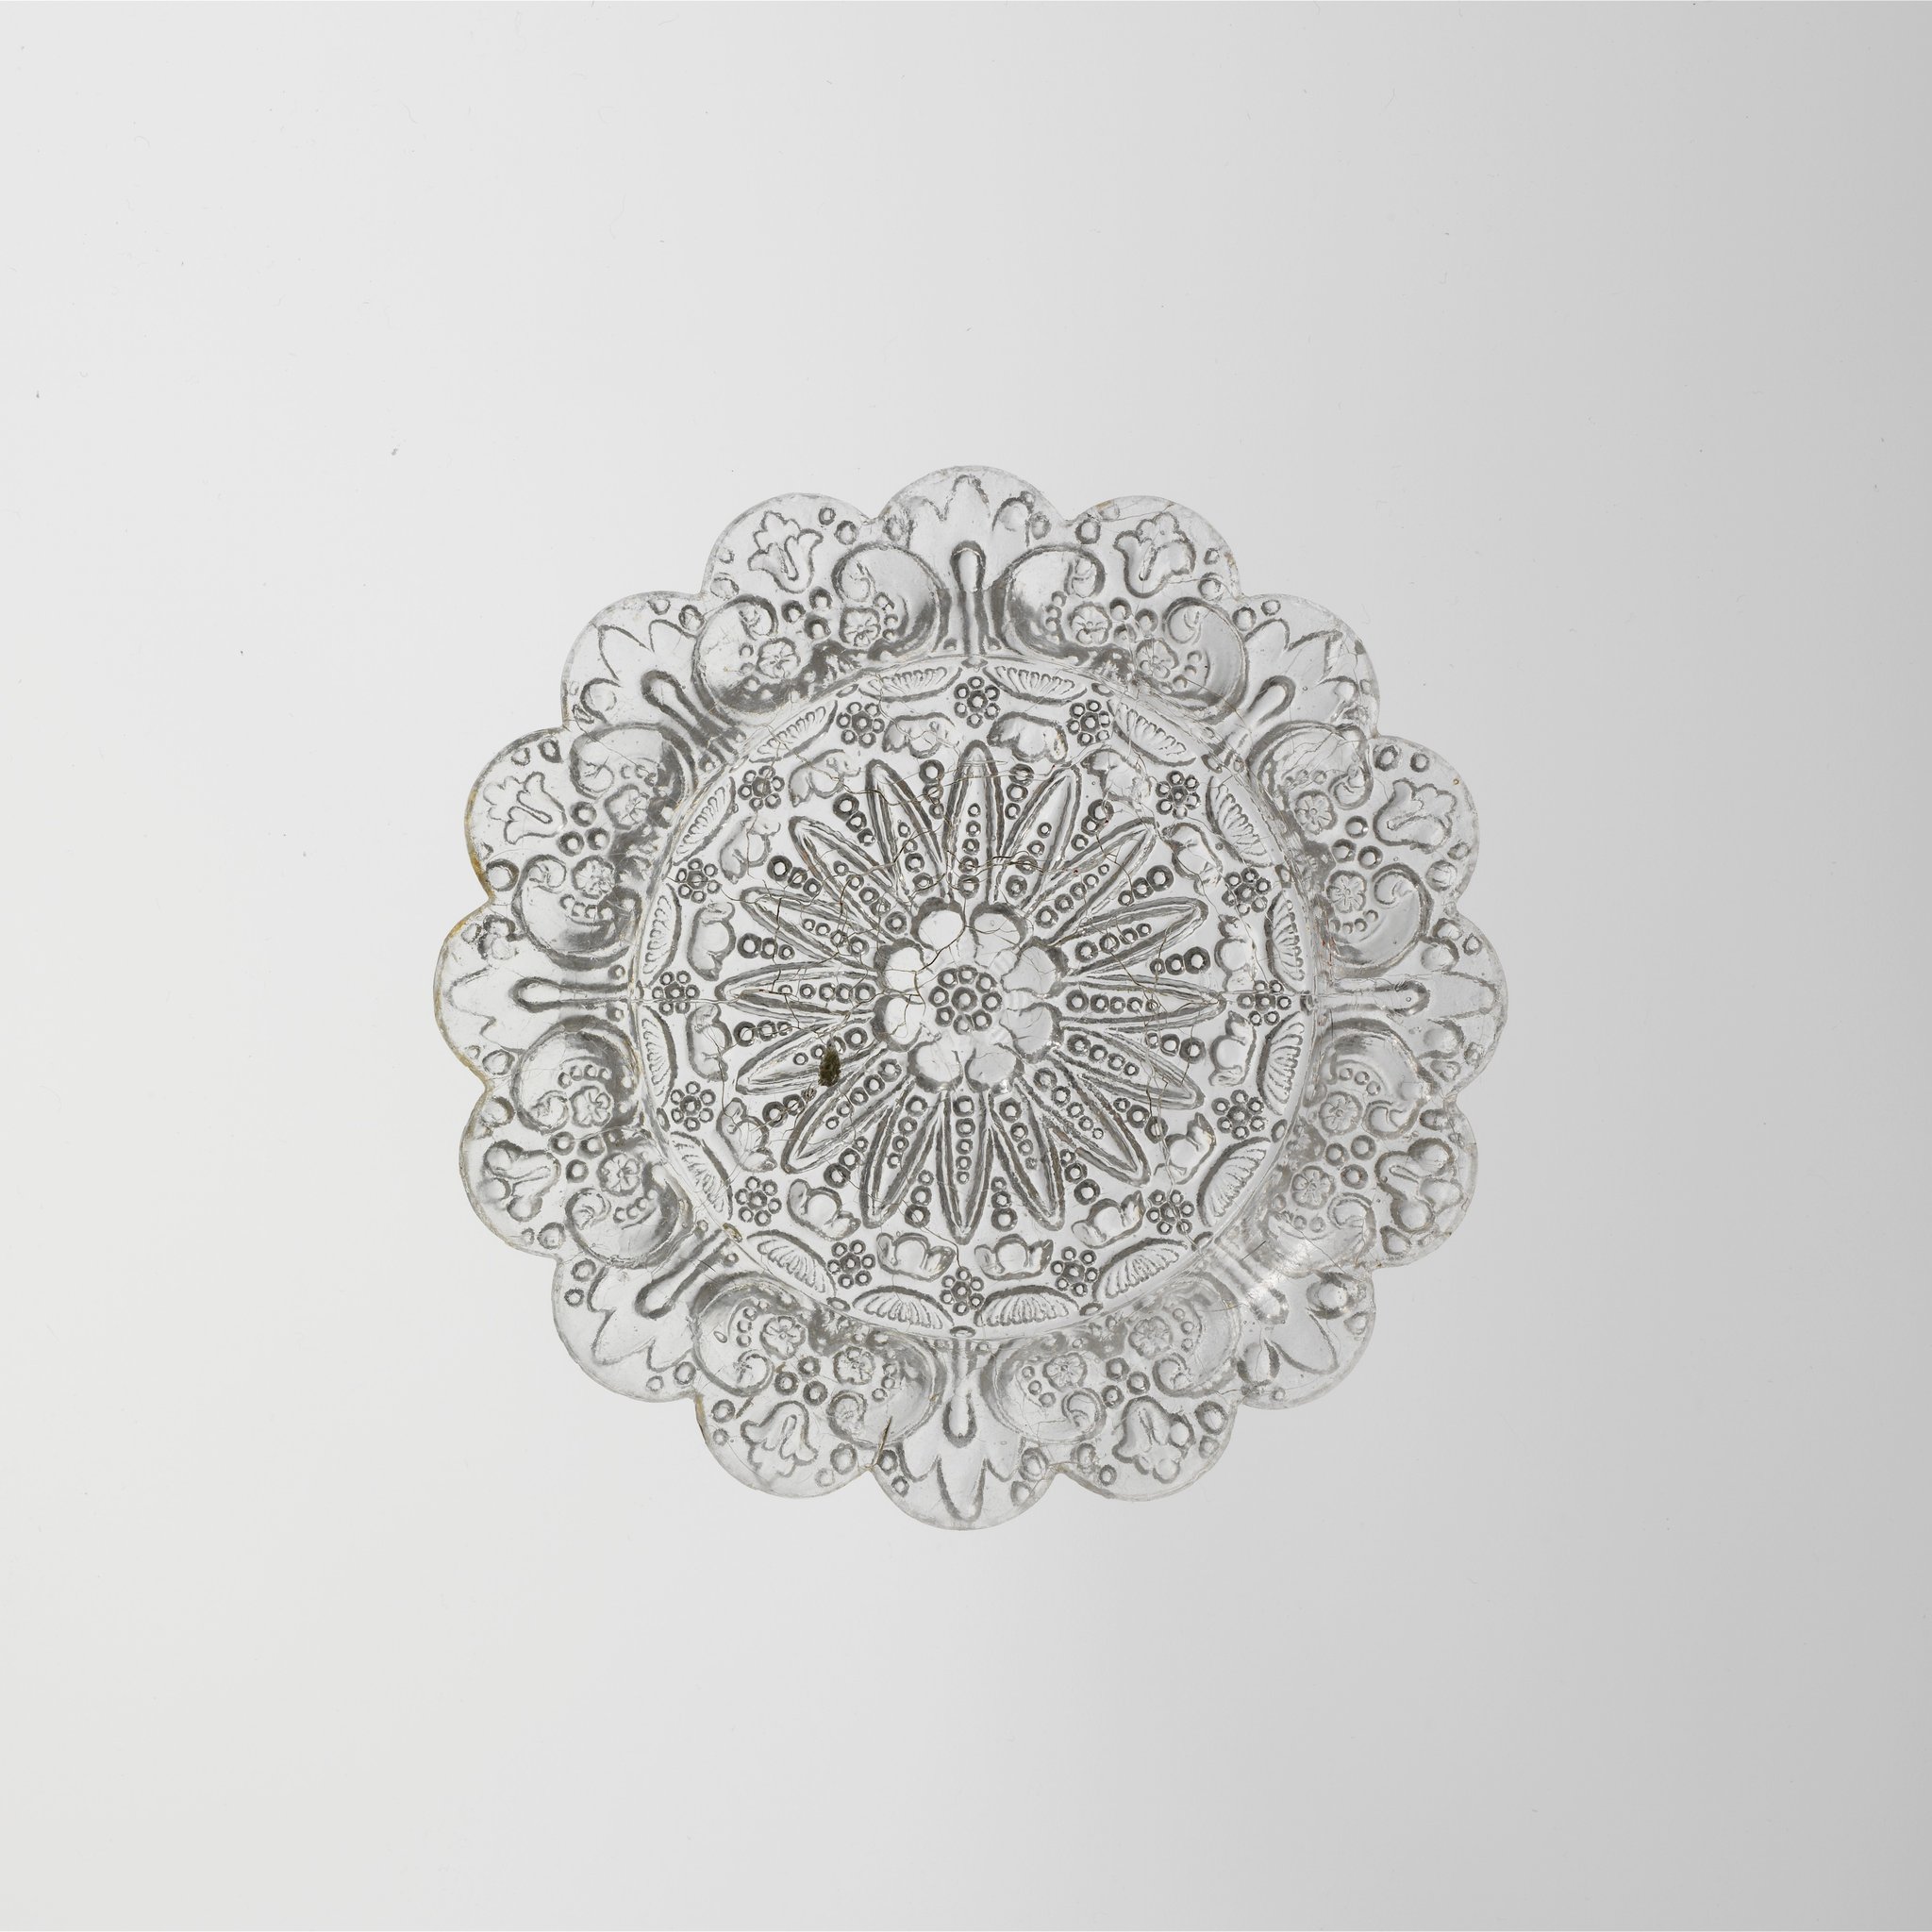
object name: cup plate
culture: american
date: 1825-1860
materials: glass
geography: united states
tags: flowers